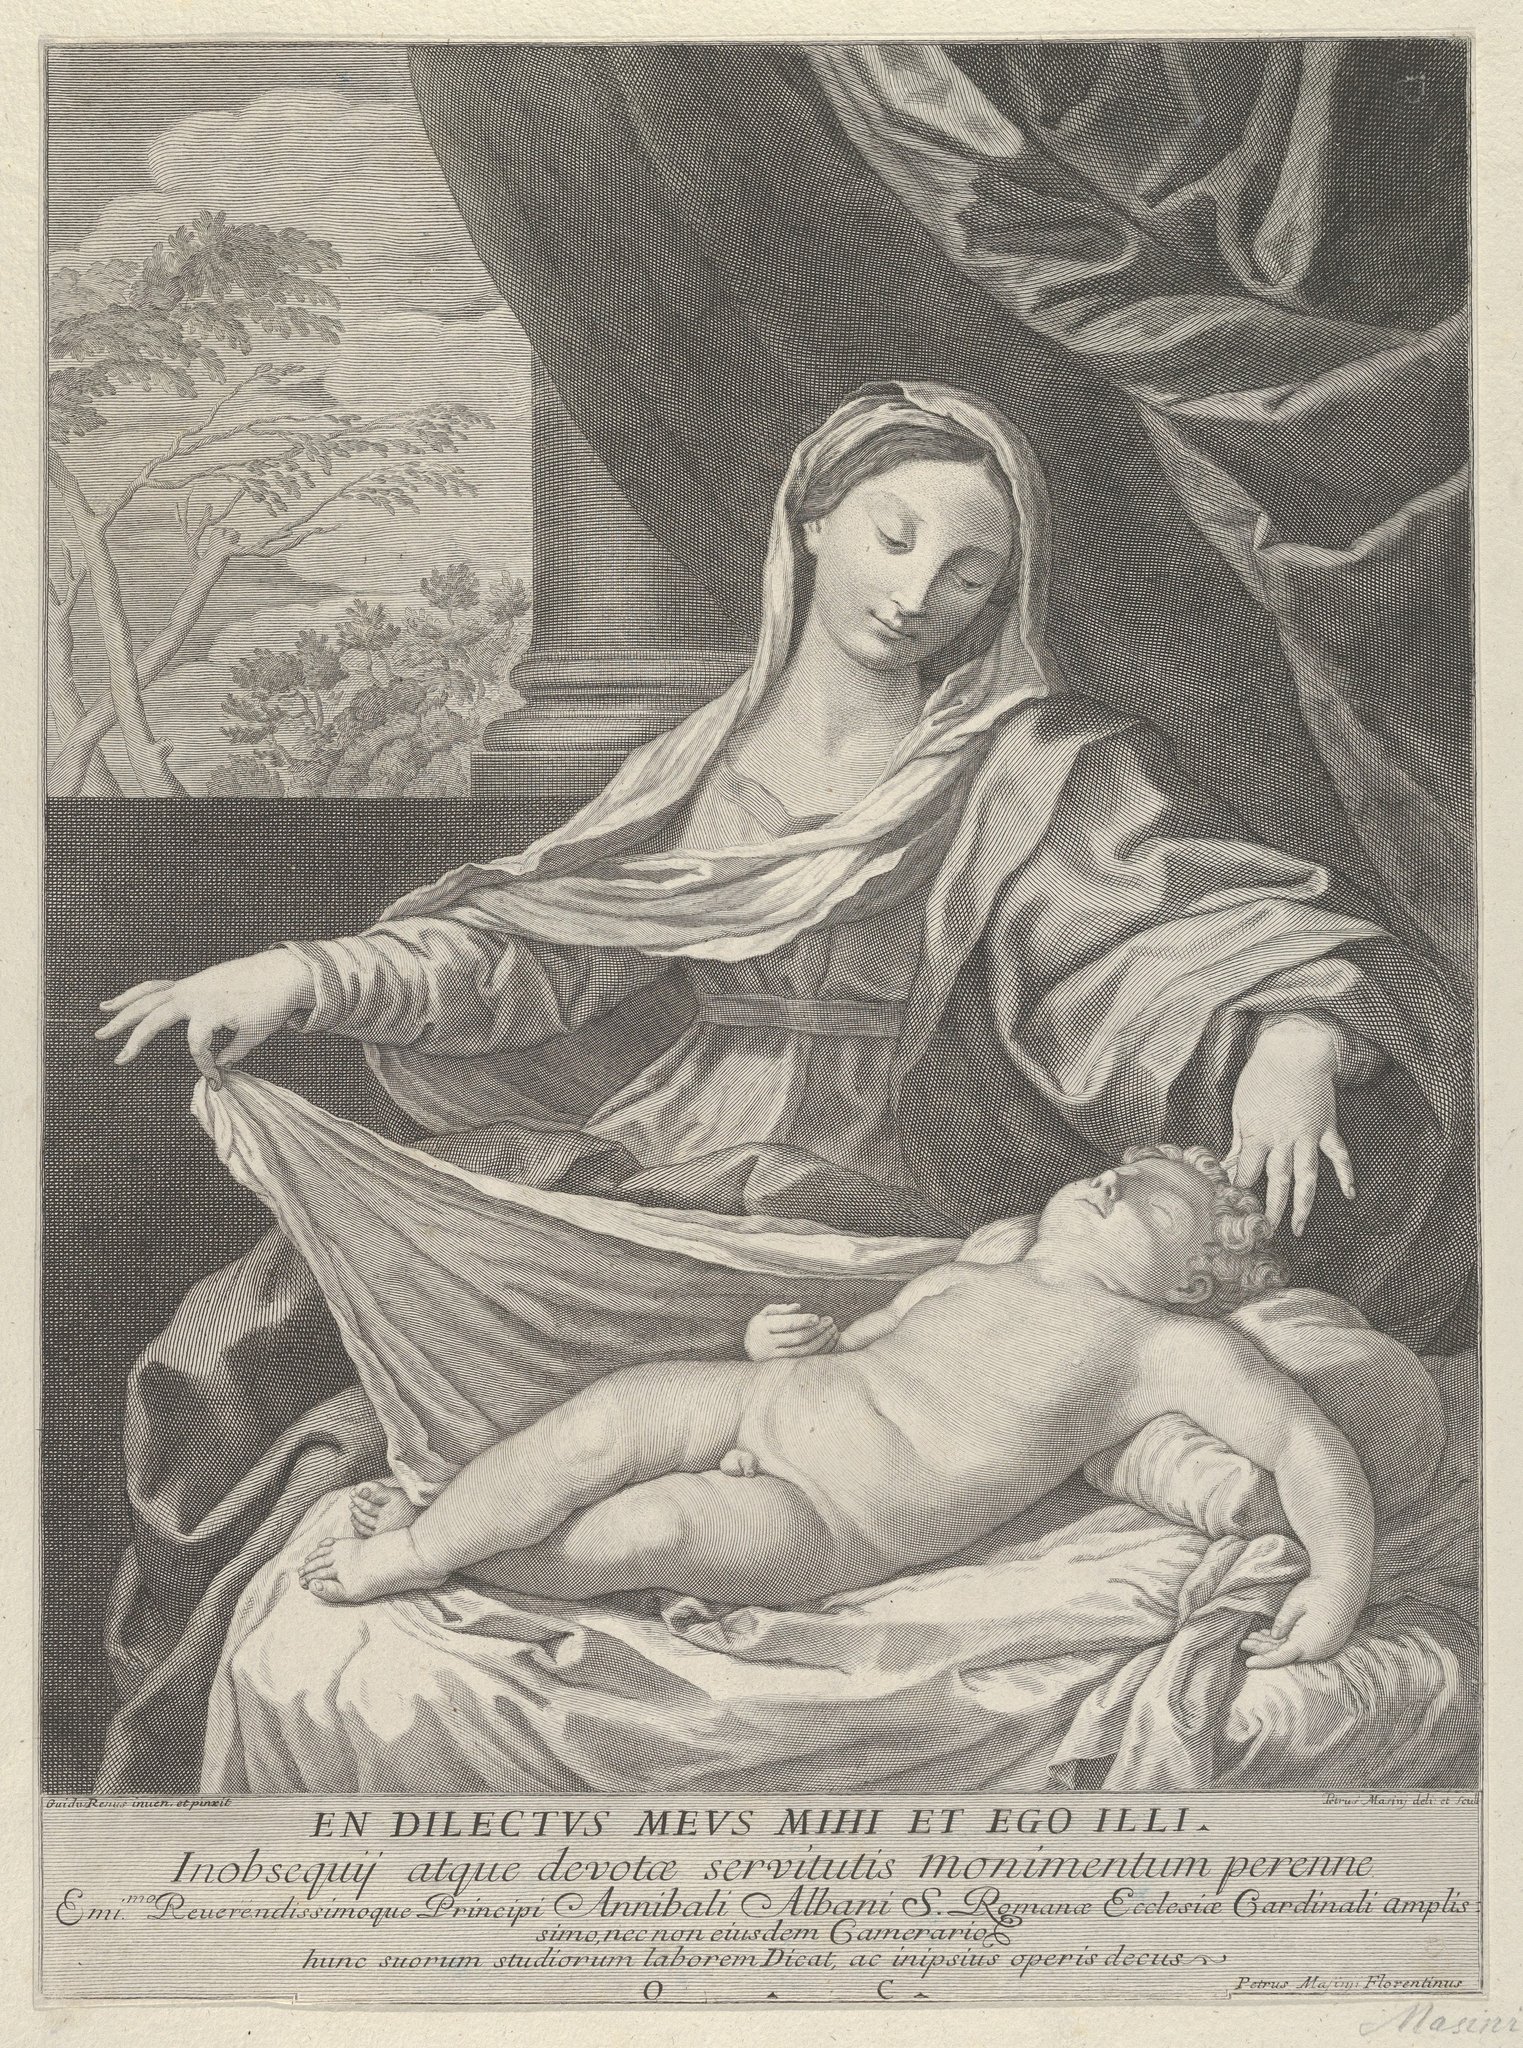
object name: print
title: The Virgin holding a cloth above the sleeping infant Christ, after Reni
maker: pietro masini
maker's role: engraver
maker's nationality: italian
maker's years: 1700-1800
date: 1700-1800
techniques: engraving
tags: sleeping,madonna and child